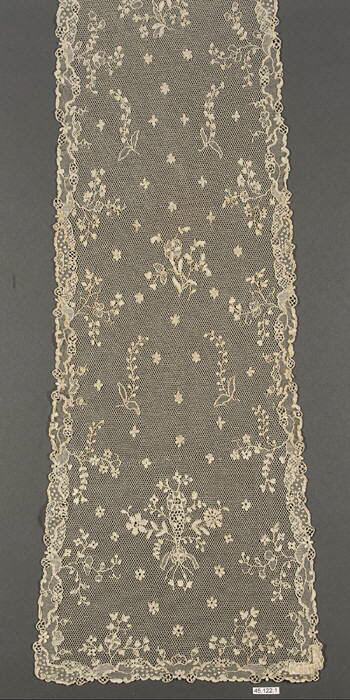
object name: quille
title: Quille (one of a pair)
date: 1701-1800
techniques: lace